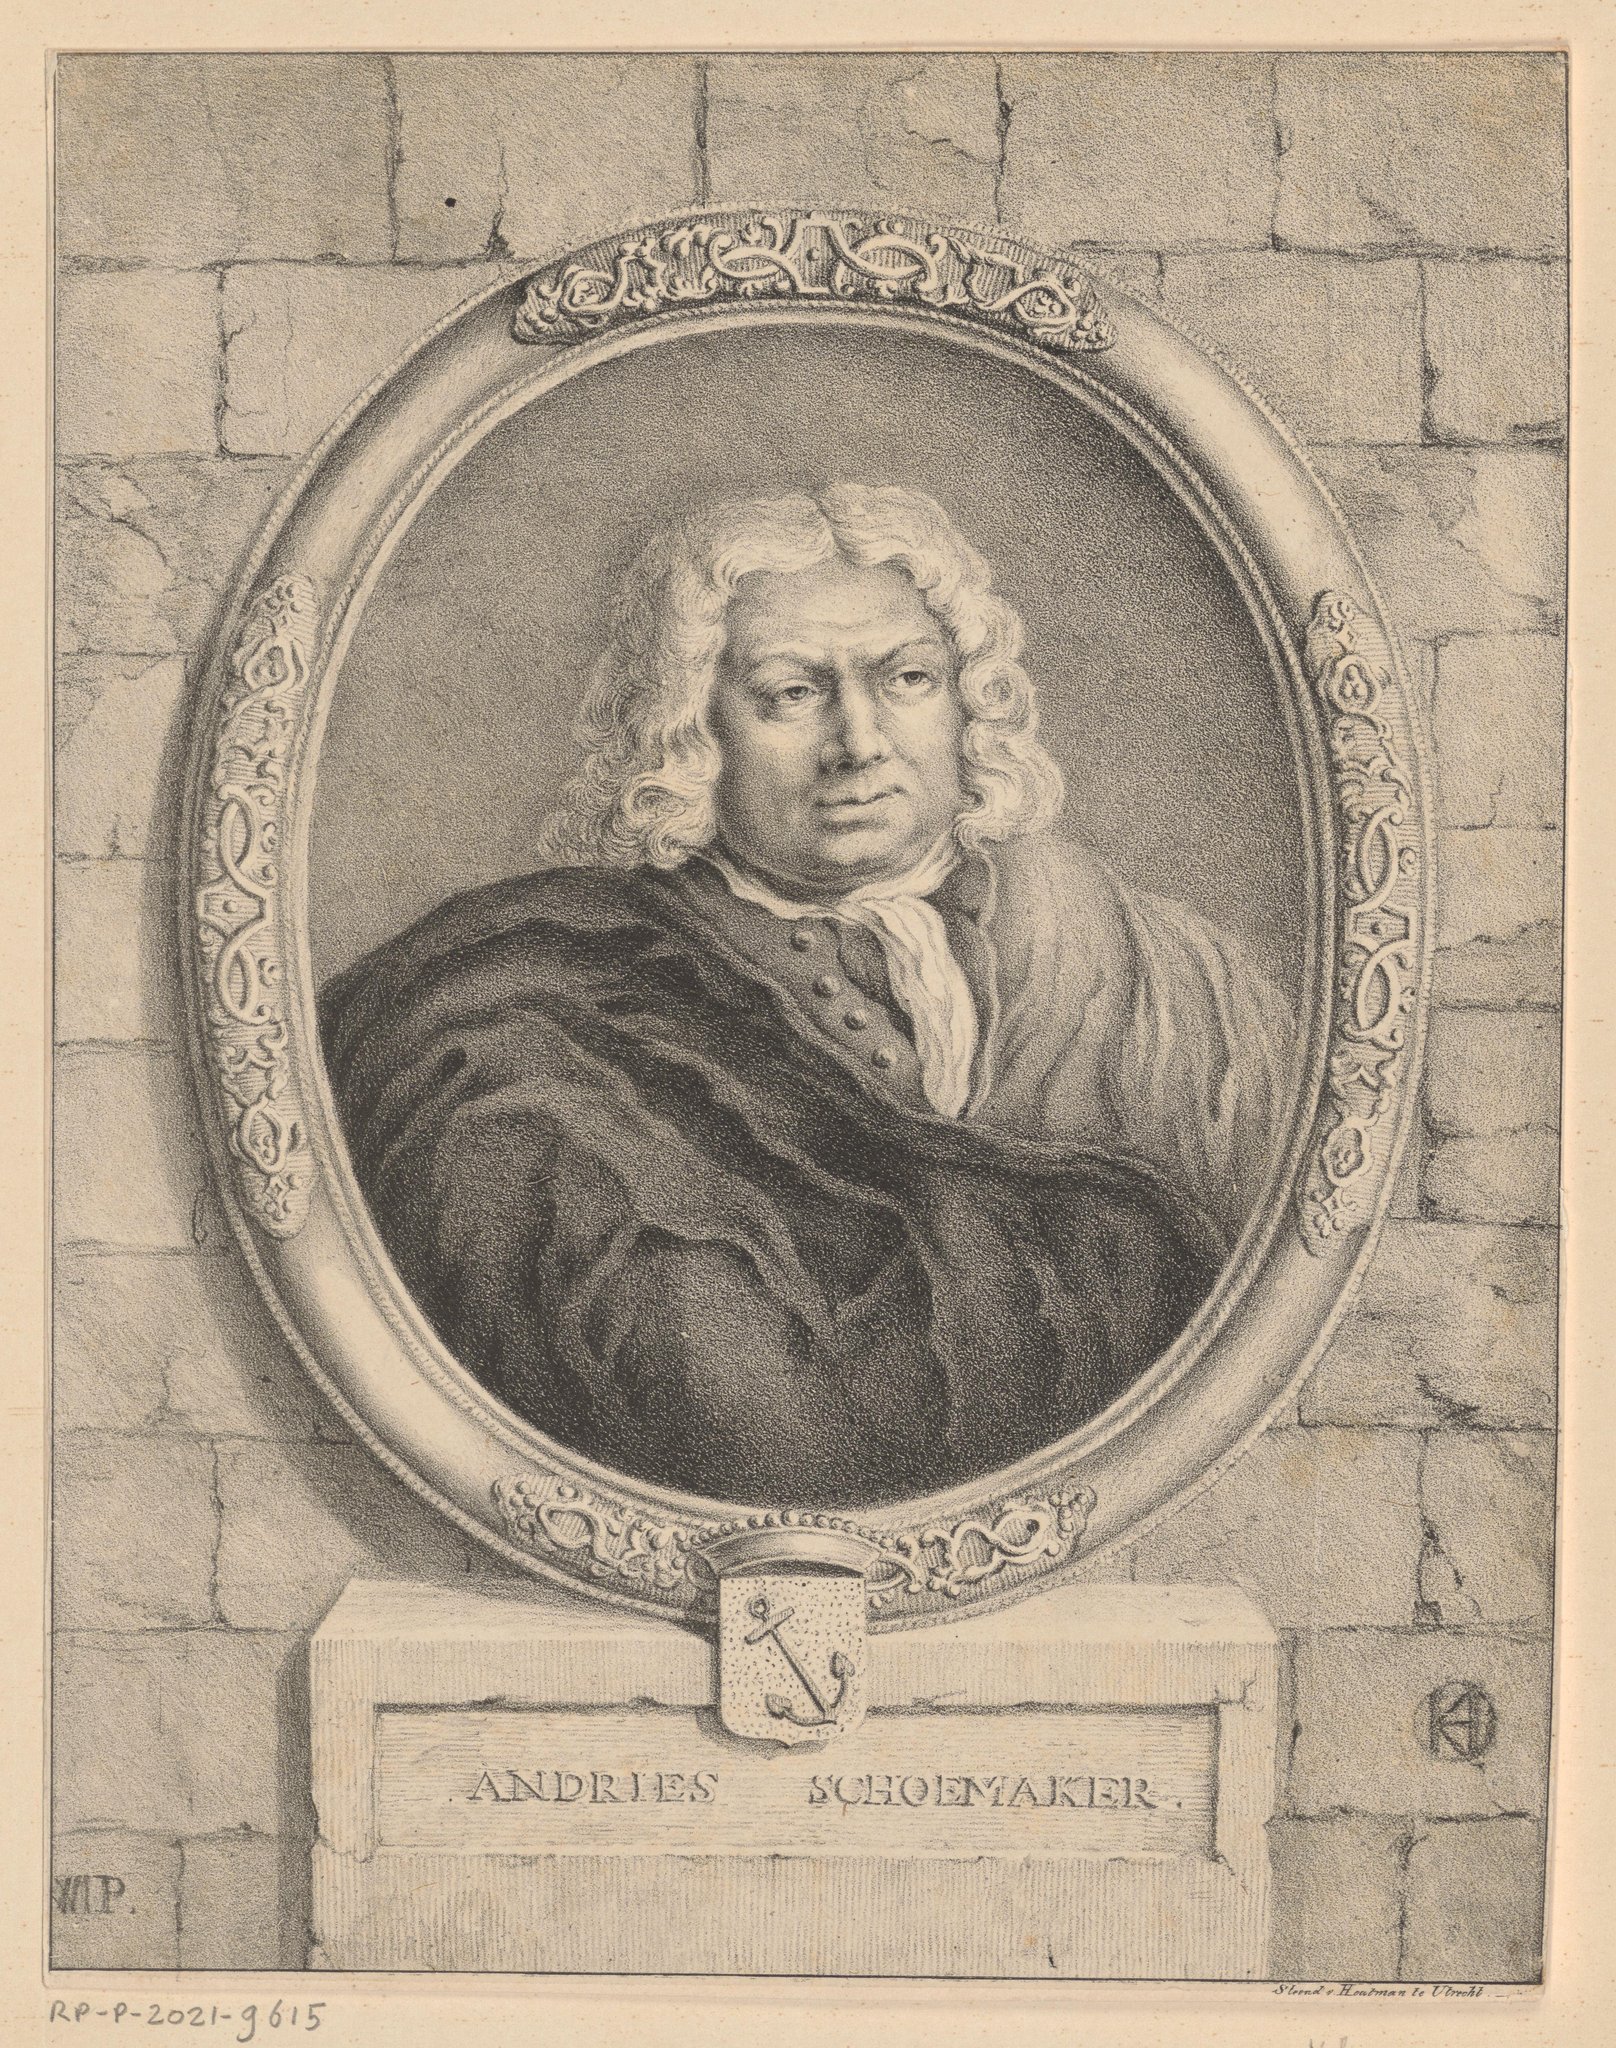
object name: print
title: Portret van Andries Schoemaker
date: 1828-1843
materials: paper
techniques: lithograph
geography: utrecht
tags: draughtsman, andries schoemaker, scholar, philosopher, historical persons, portrait, self-portrait of artist, armorial bearing, heraldry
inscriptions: monogram: ‘H[...]’